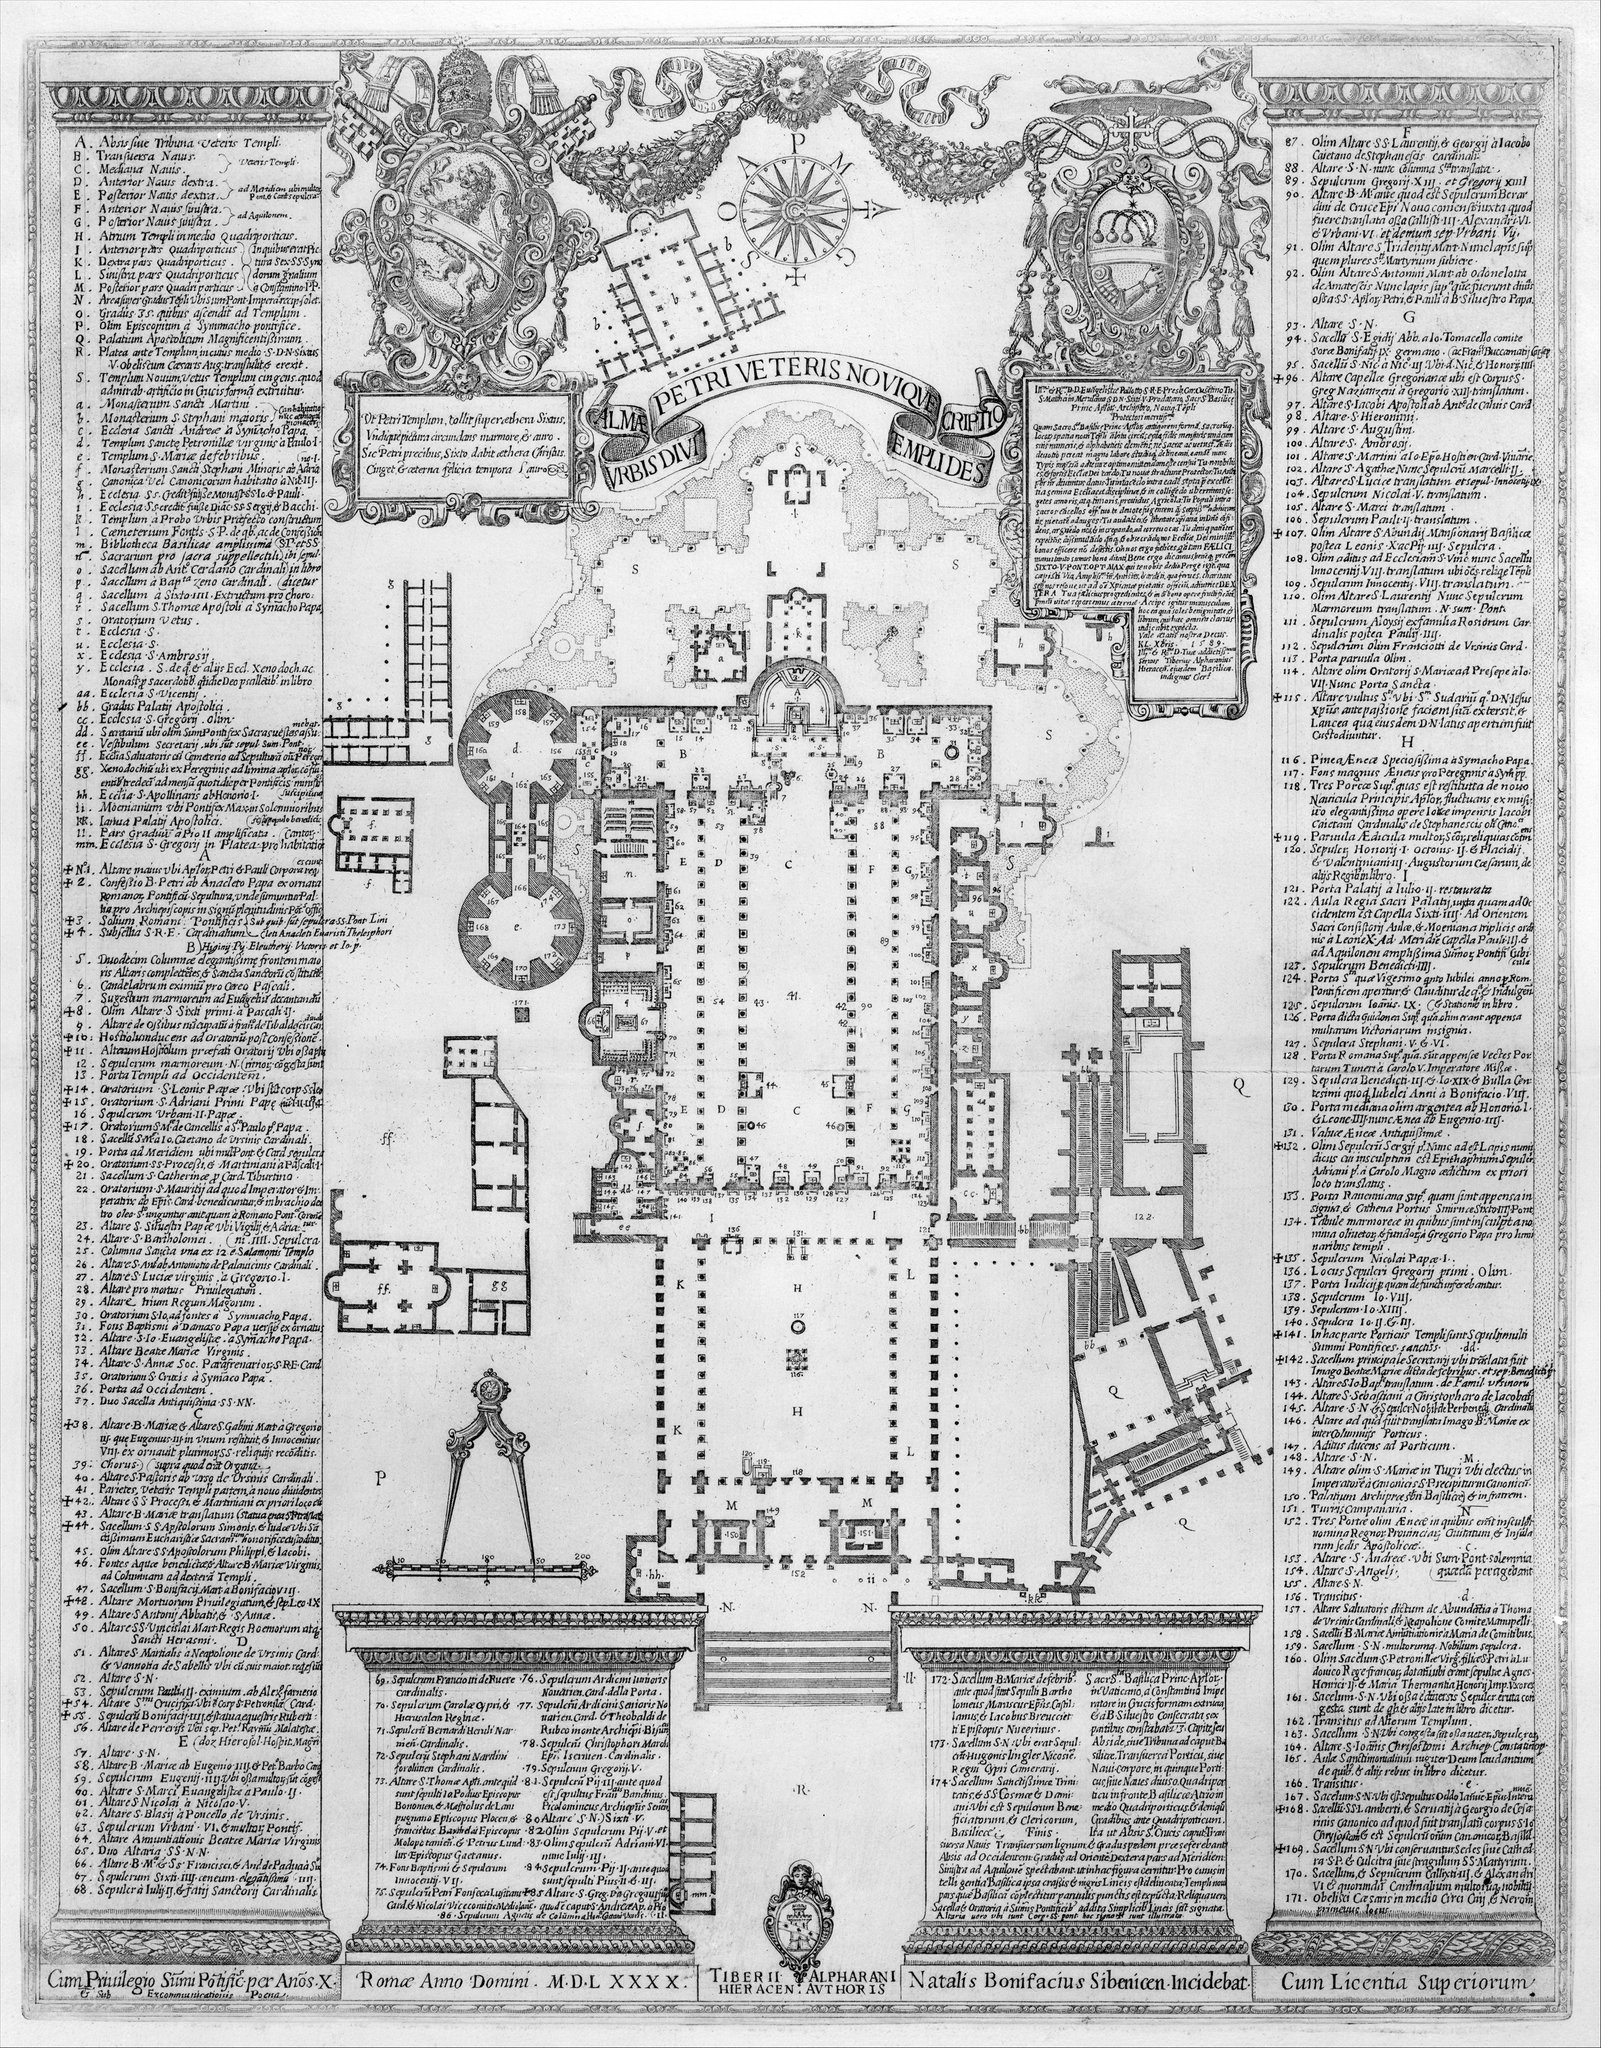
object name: album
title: Basilica di S. Pietro in Vaticano (spine title)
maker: giovanni battista costaguti the elder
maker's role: author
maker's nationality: italian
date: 1620-1684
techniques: engraving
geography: rome?